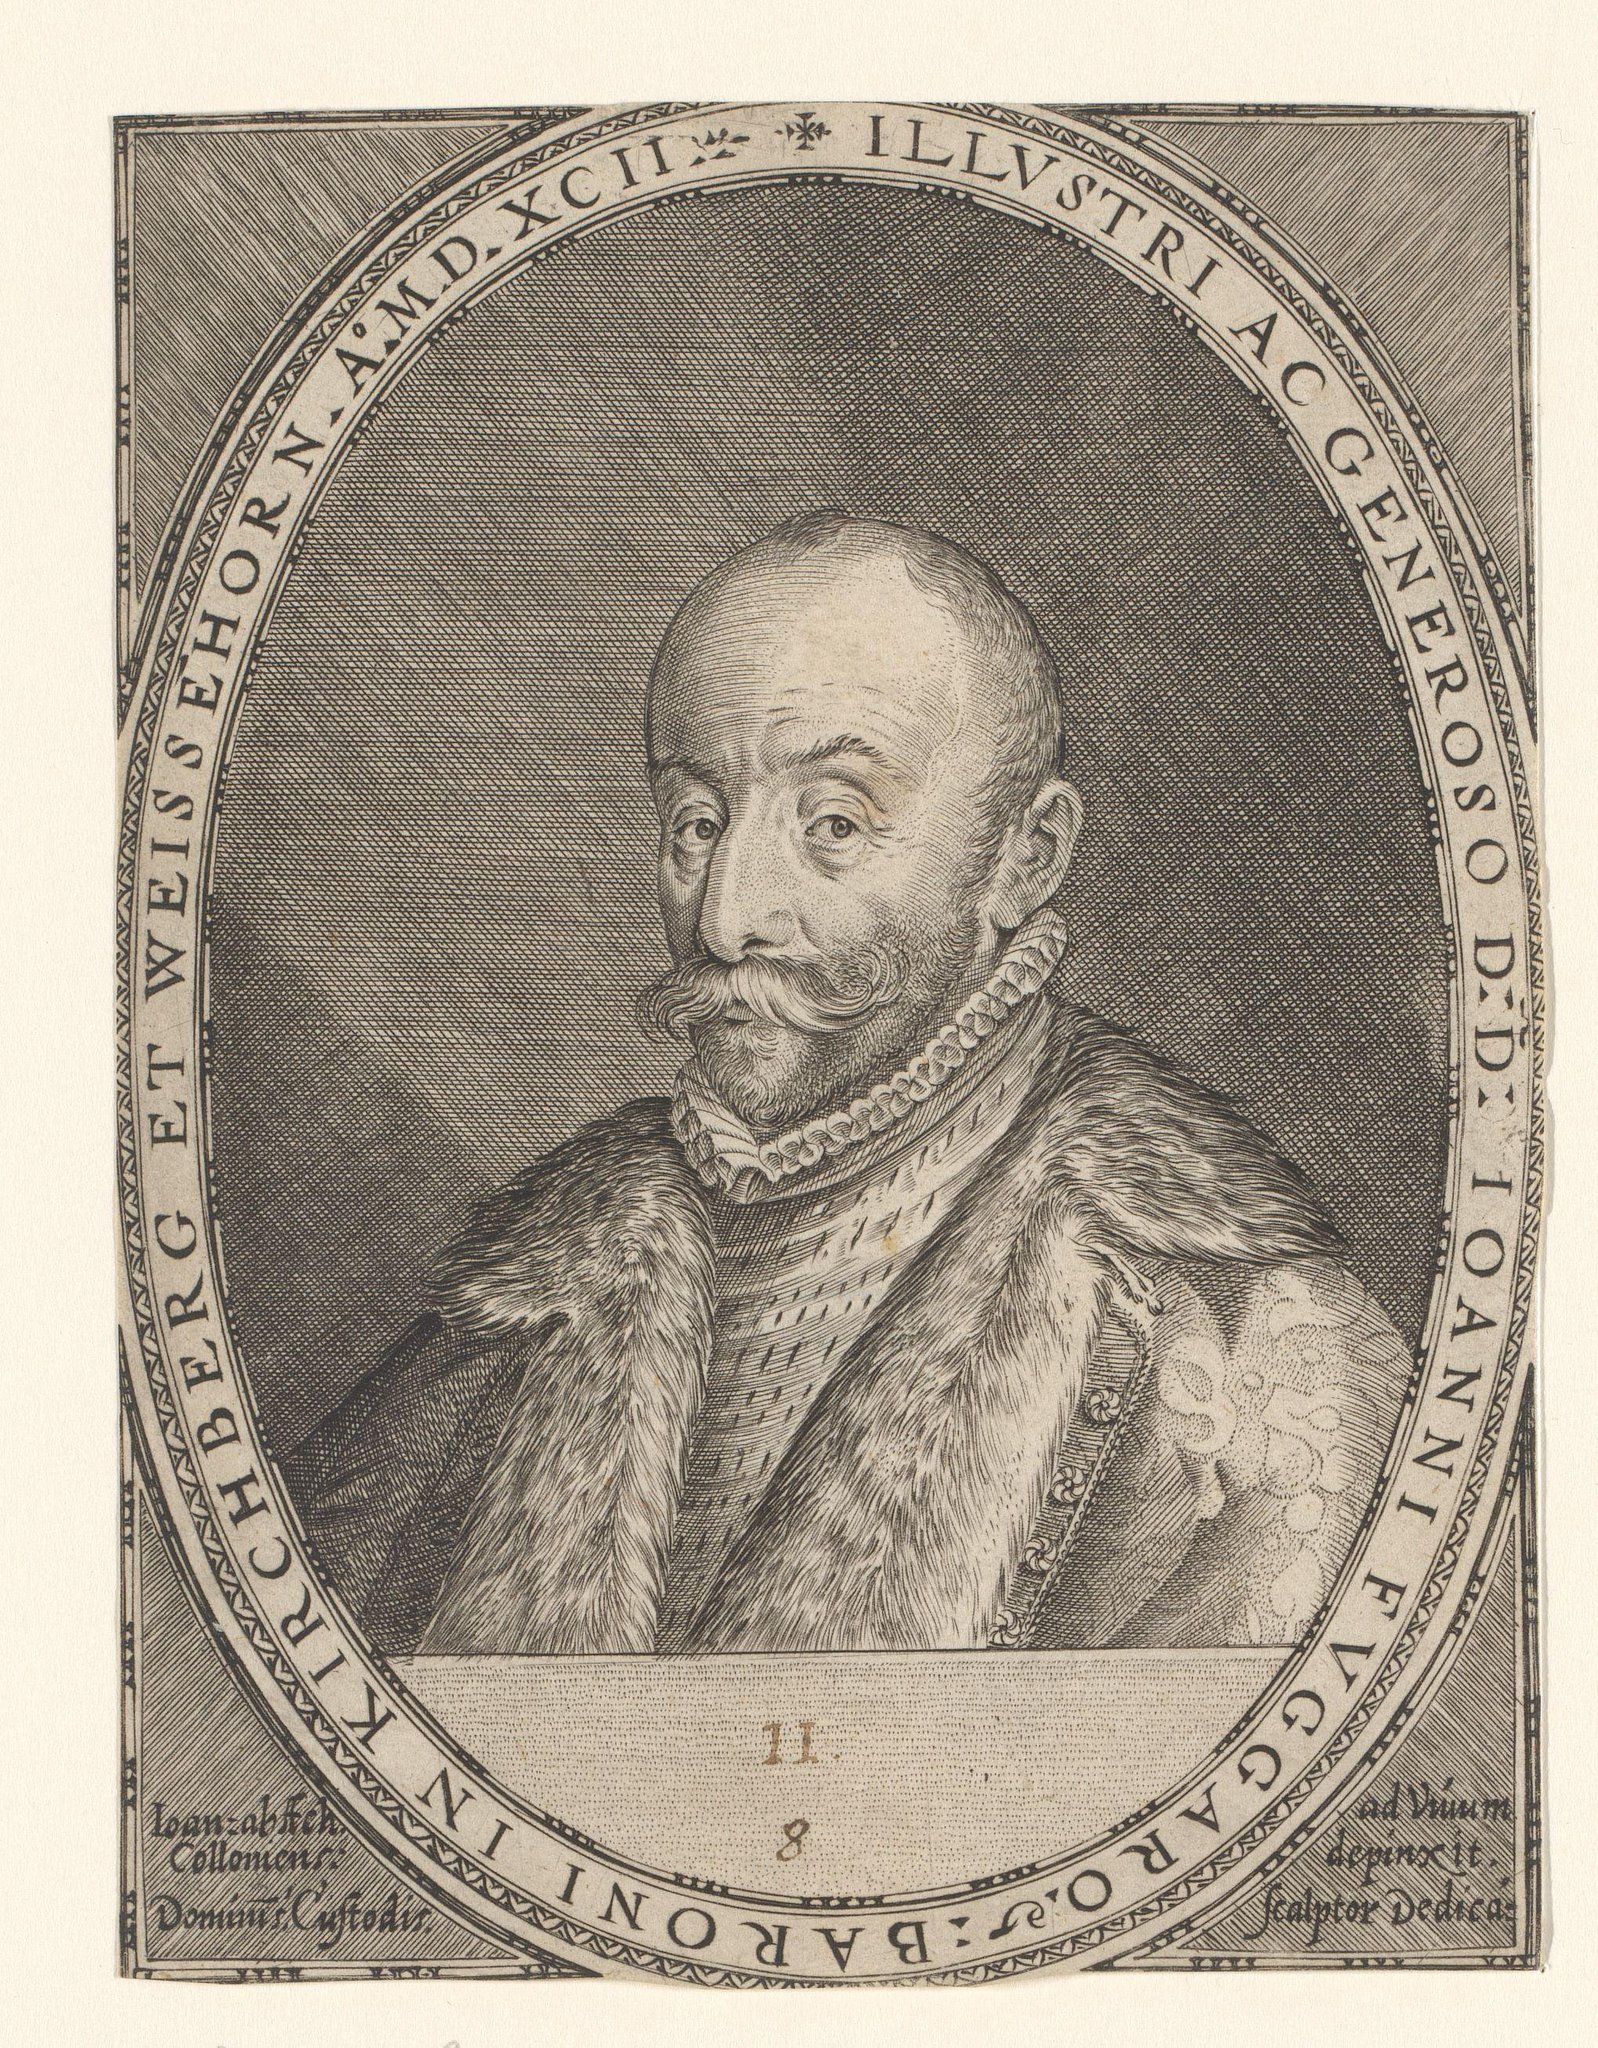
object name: print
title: Portret Johannes Fugger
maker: dominicus custos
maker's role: print maker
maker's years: 1560-1615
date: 1552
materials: paper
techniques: engraving